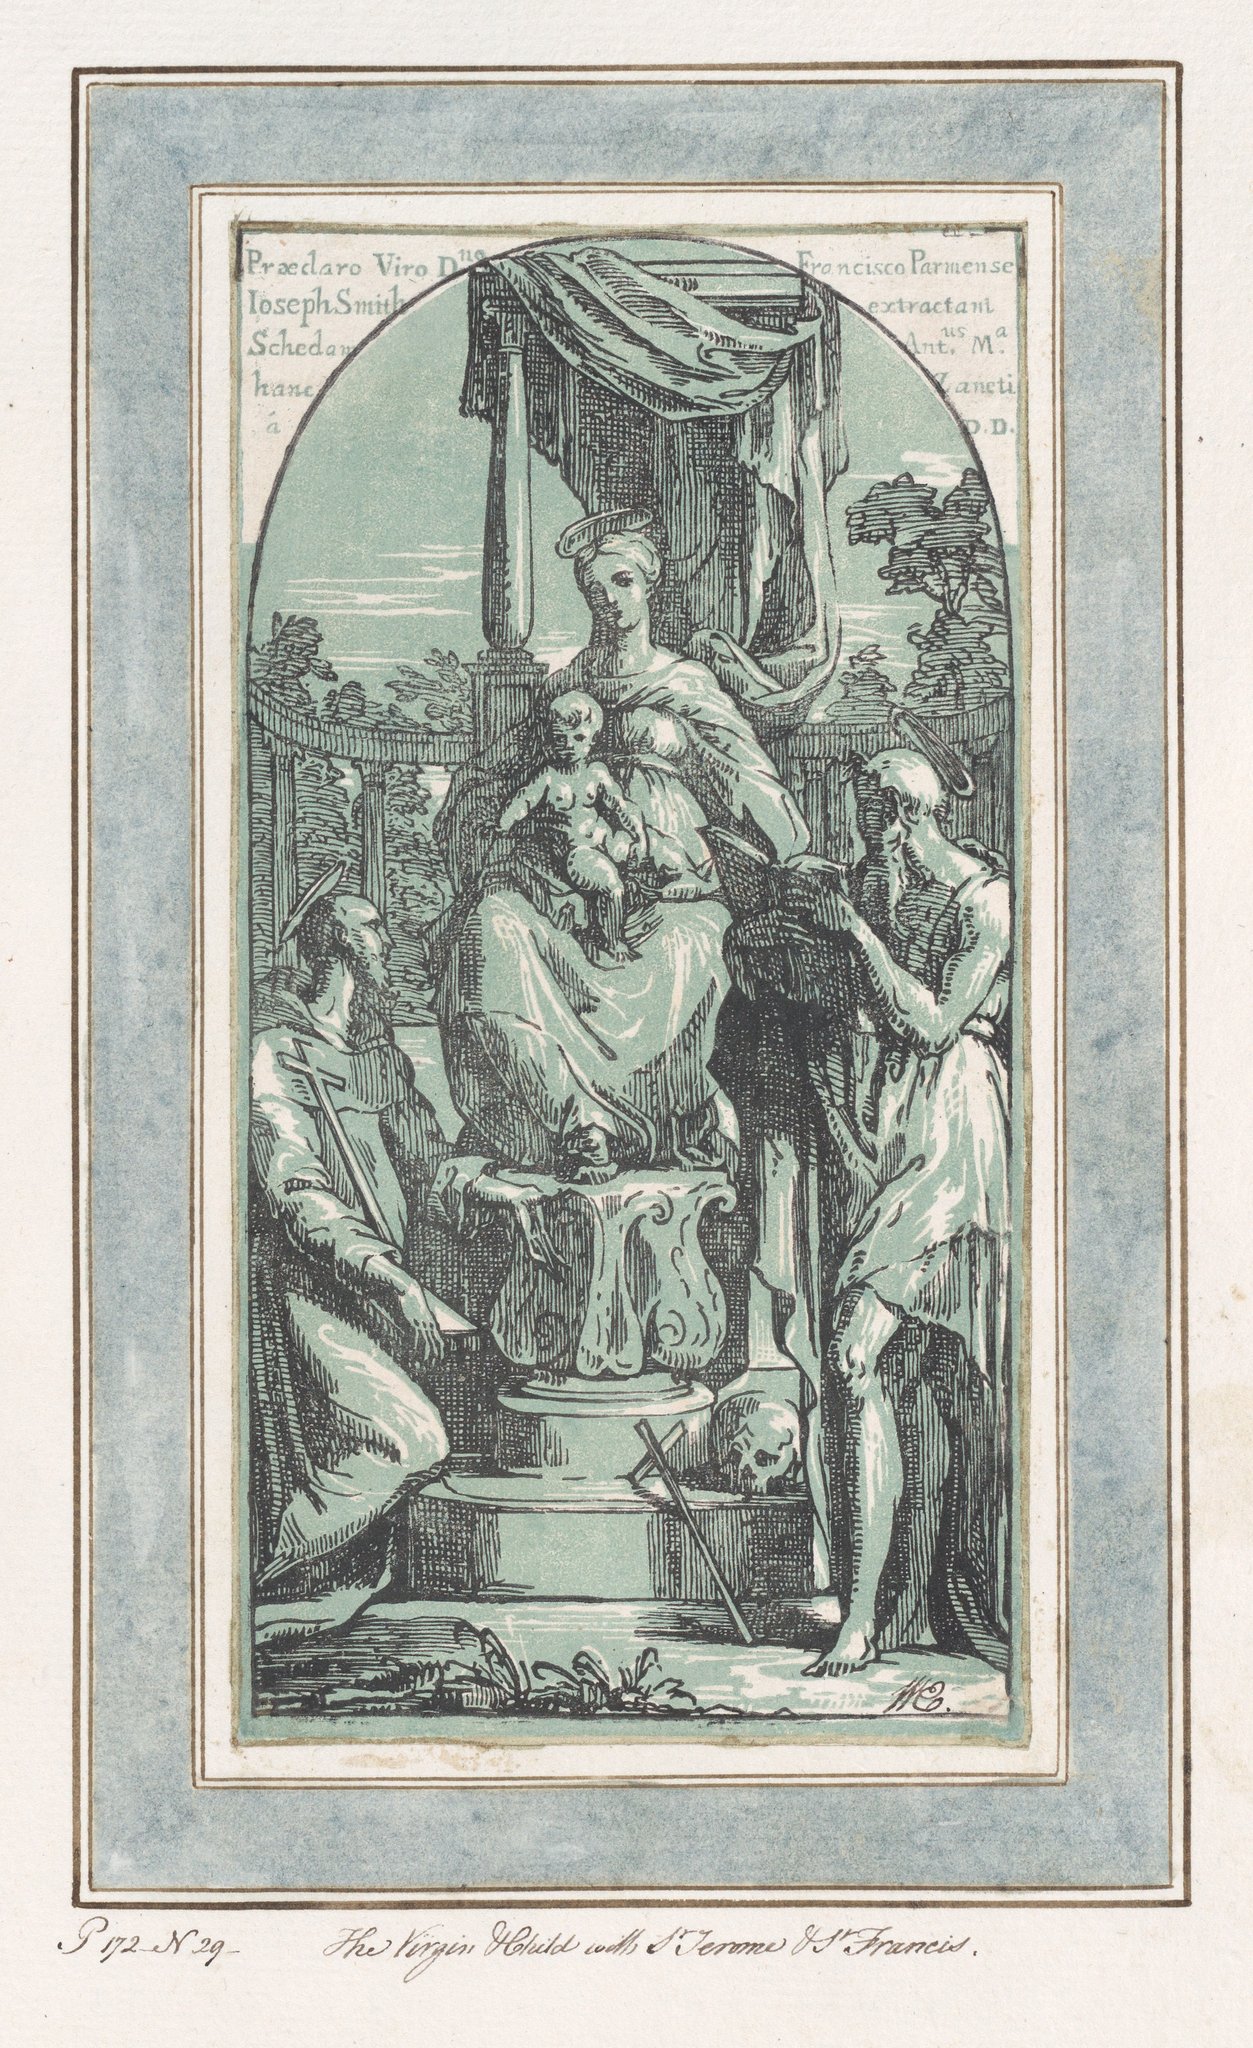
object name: print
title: The Virgin and Child Enthroned, Saint Jerome at lower right, Saint Francis at lower left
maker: conte anton maria zanetti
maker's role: artist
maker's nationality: italian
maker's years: 1680-1767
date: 1749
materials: gold, watercolor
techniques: woodcut, printing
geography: venice